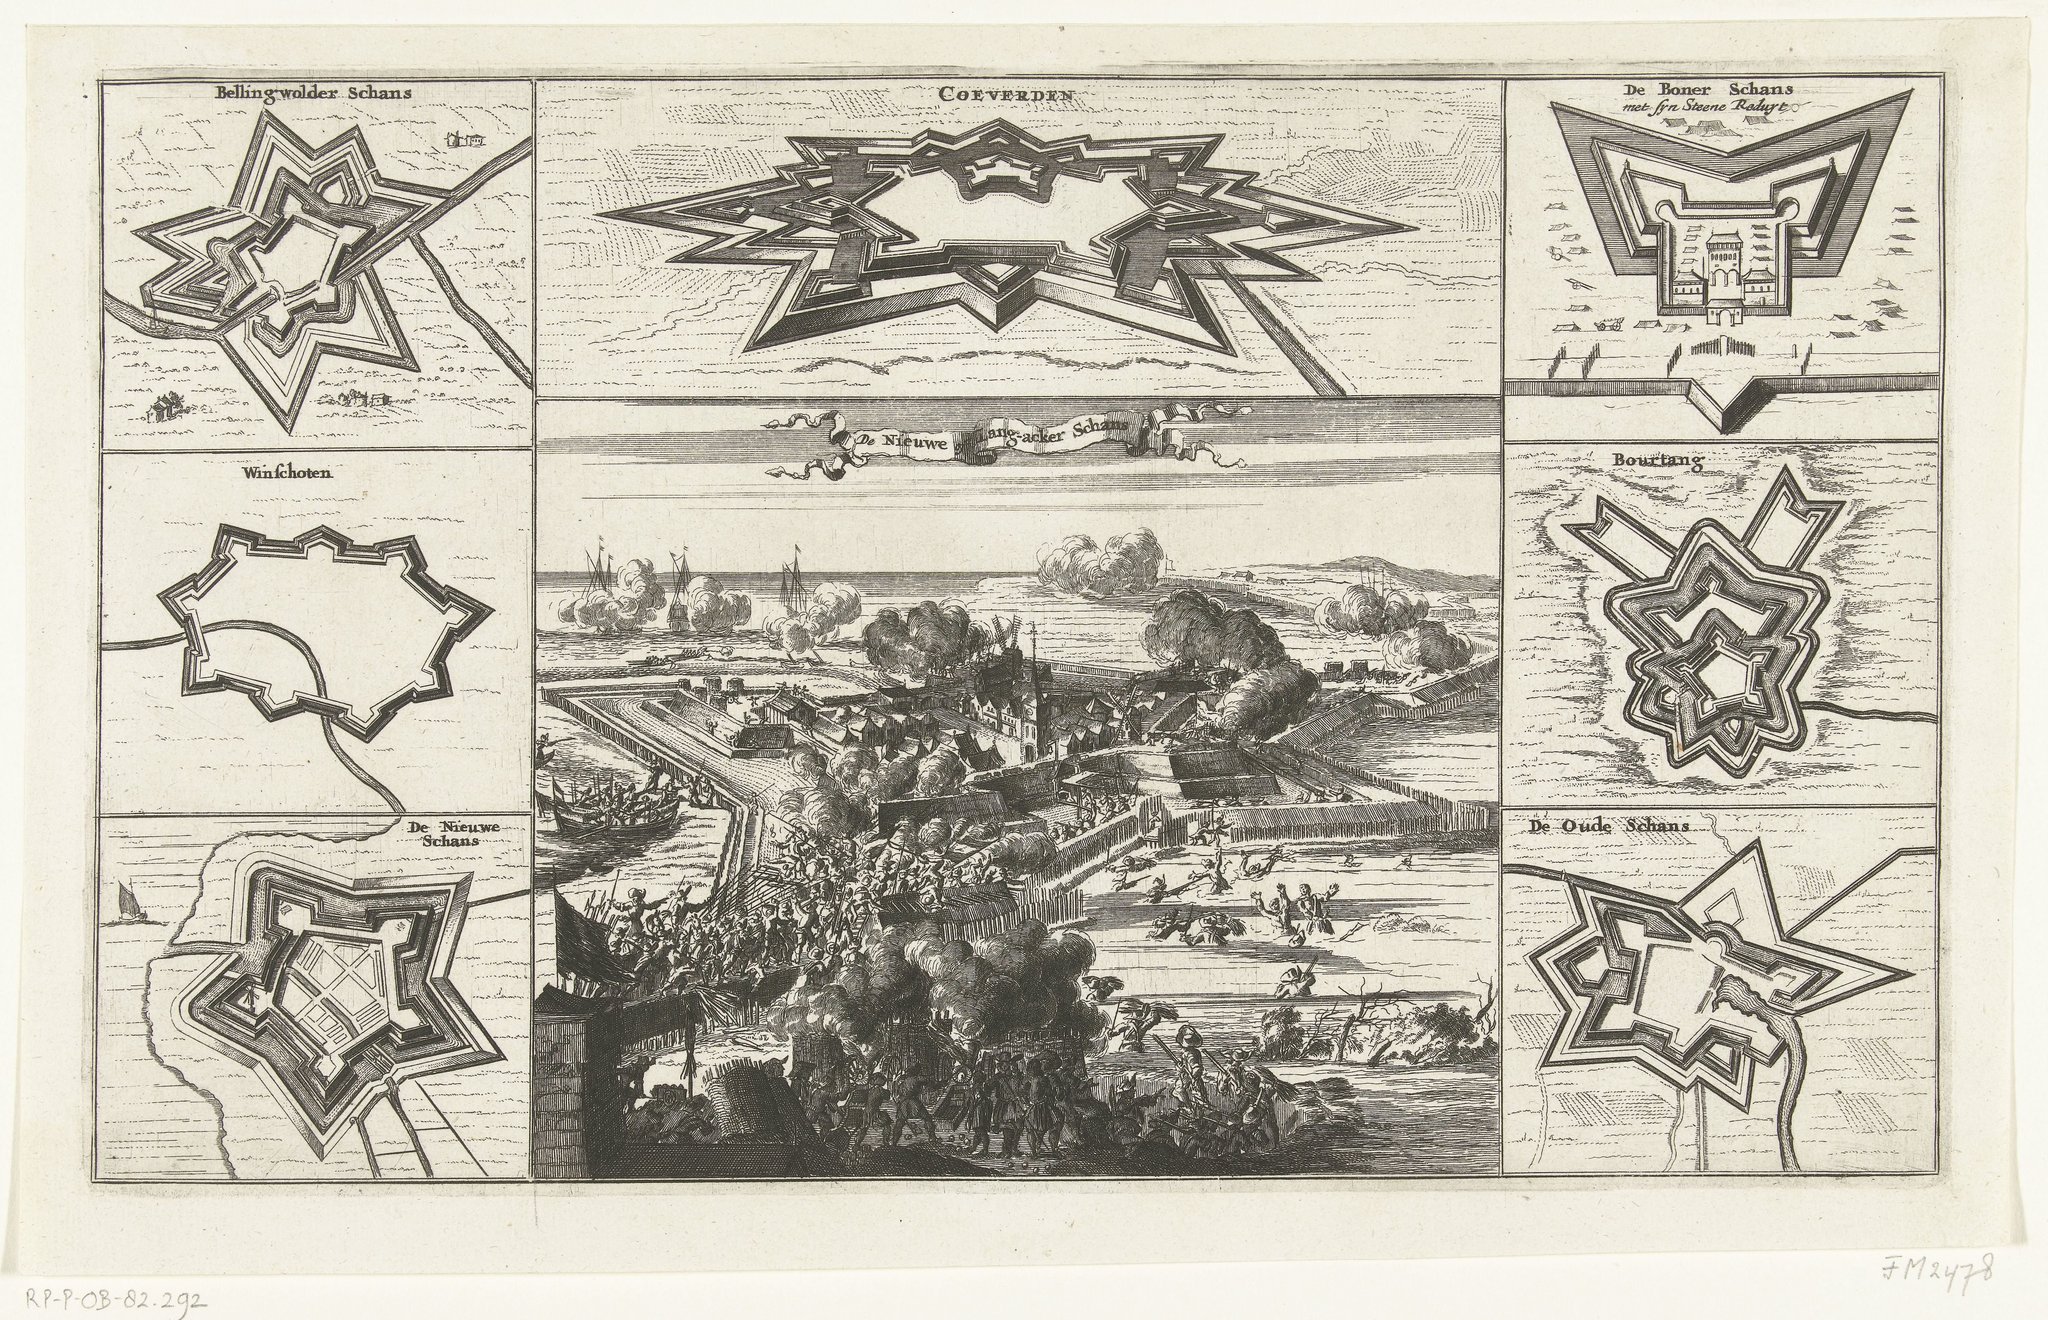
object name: history print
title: De verovering van Nieuweschans 1673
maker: Anonymous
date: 1673-1675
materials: paper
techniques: etching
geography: northern netherlands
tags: fortress, capture of city (after the siege), maps of cities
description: Gebruikt als illustratie in: Lambert van den Bosch, Tooneel des oorlogs, opgerecht in de Vereenigde Nederlanden door de wapenen van de koningen van Vrankryk en Engeland, Keulsche en Munstersche bisschoppen : tegen de Staten der Vereenigde Nederlanden, en hare geallieerden, J. van Meurs en J. van Someren, Amsterdam 1675, 4 delen, dl. IV, fol. 6.